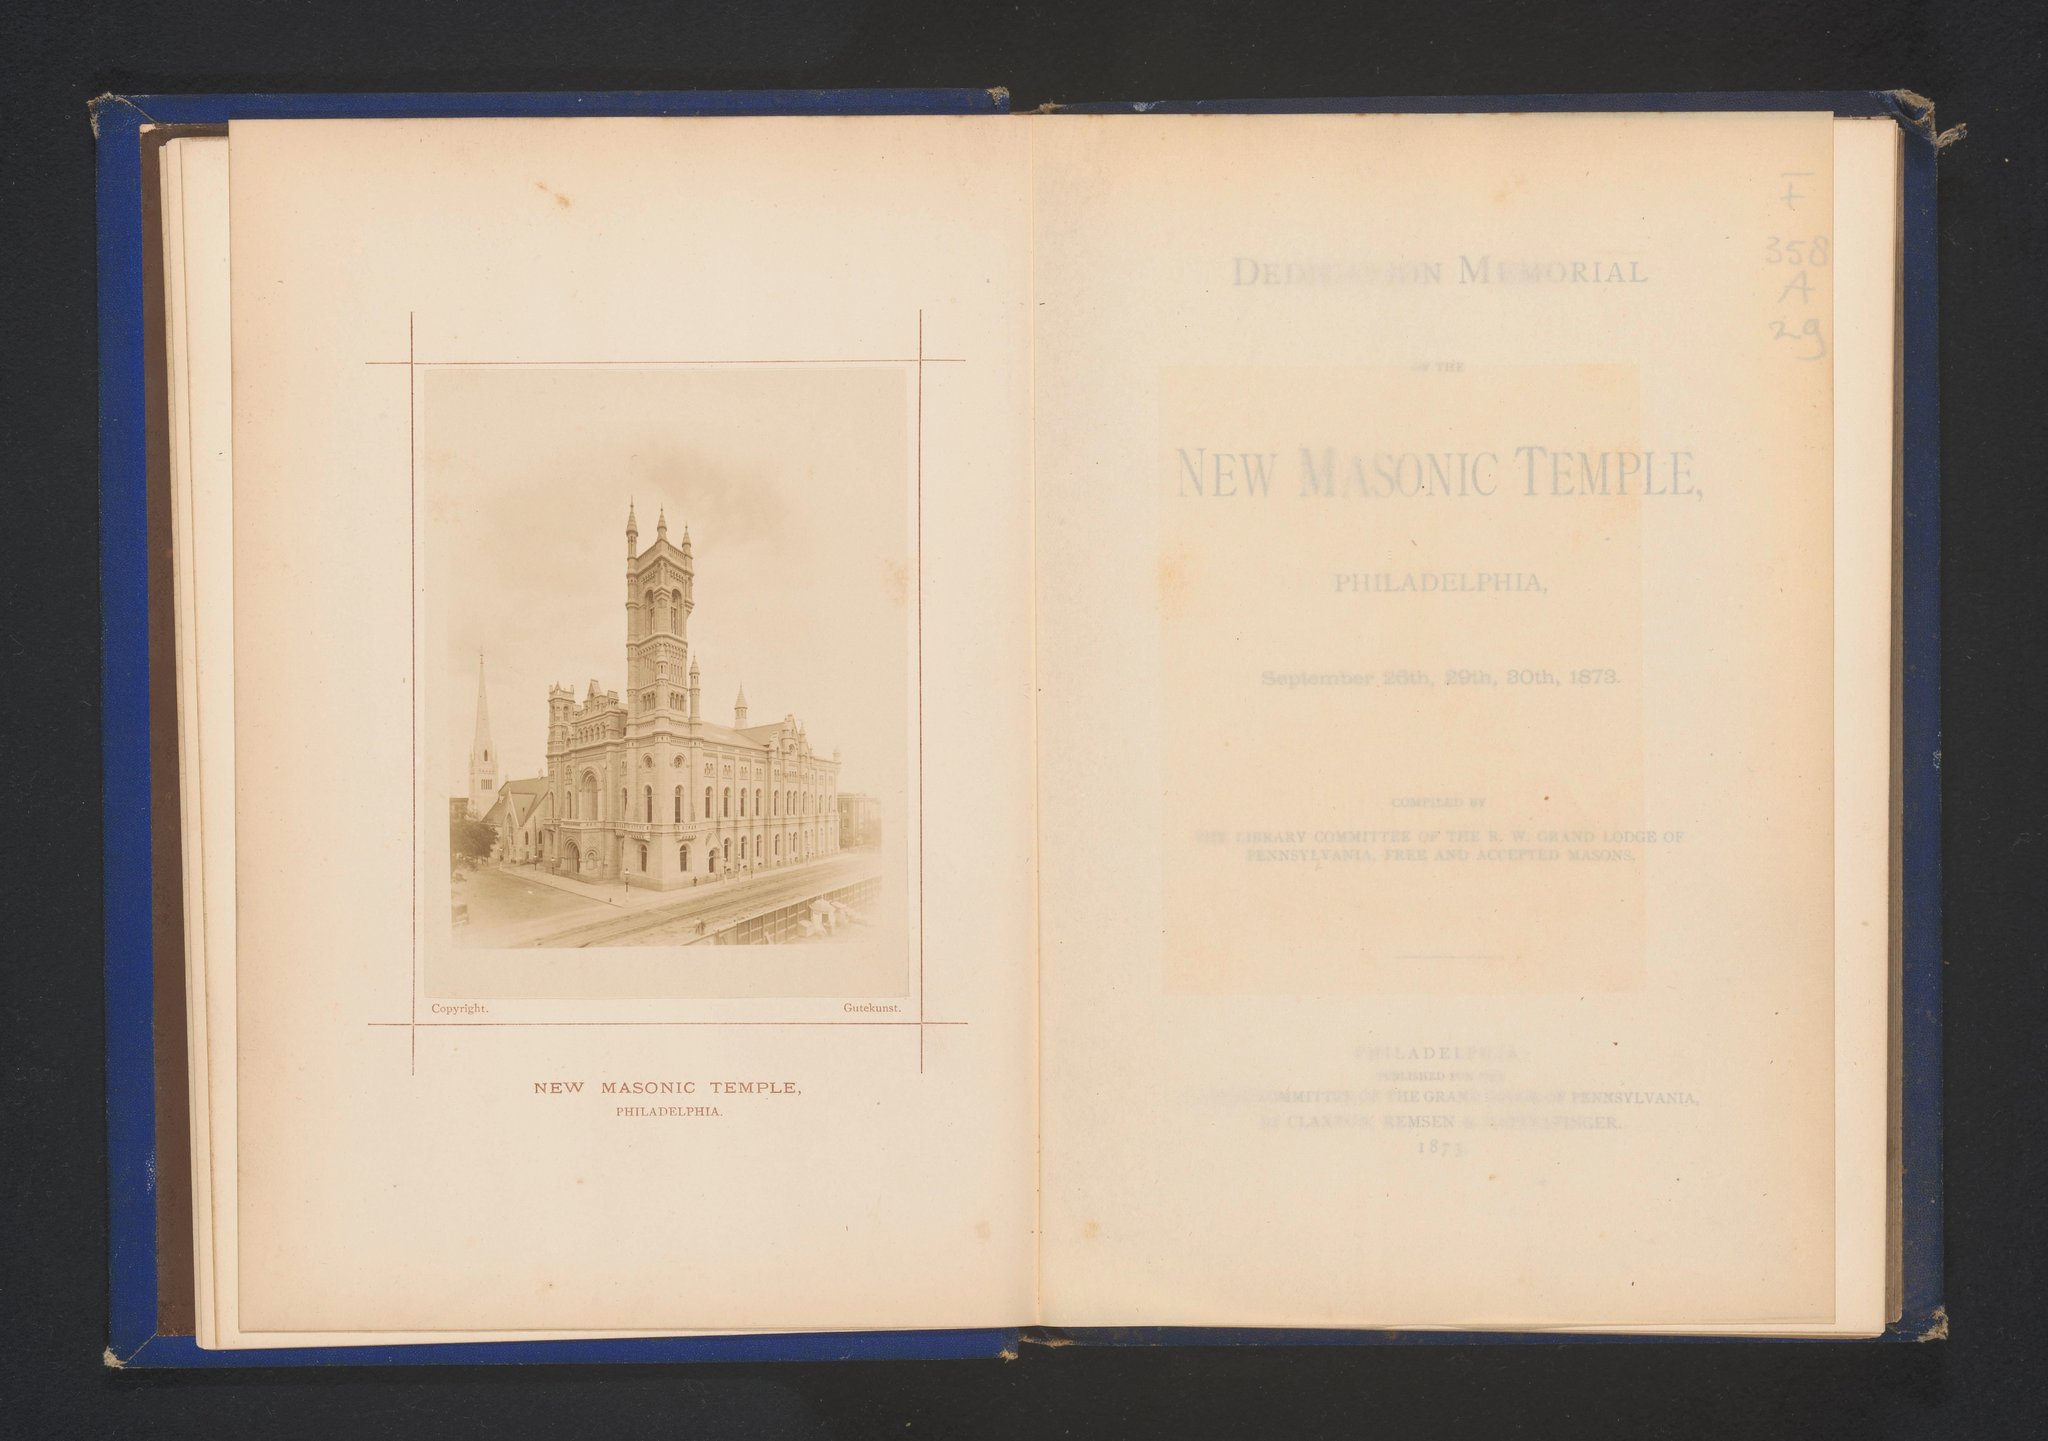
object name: page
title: New Masonic temple, Philadelphia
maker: frederick gutekunst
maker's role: fotograaf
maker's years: 1831-1917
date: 1869-1874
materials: photographic support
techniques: albumen print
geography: philadelphia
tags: miscellaneous religions, cults and doctrines: freemasonry, façade (of house or building)